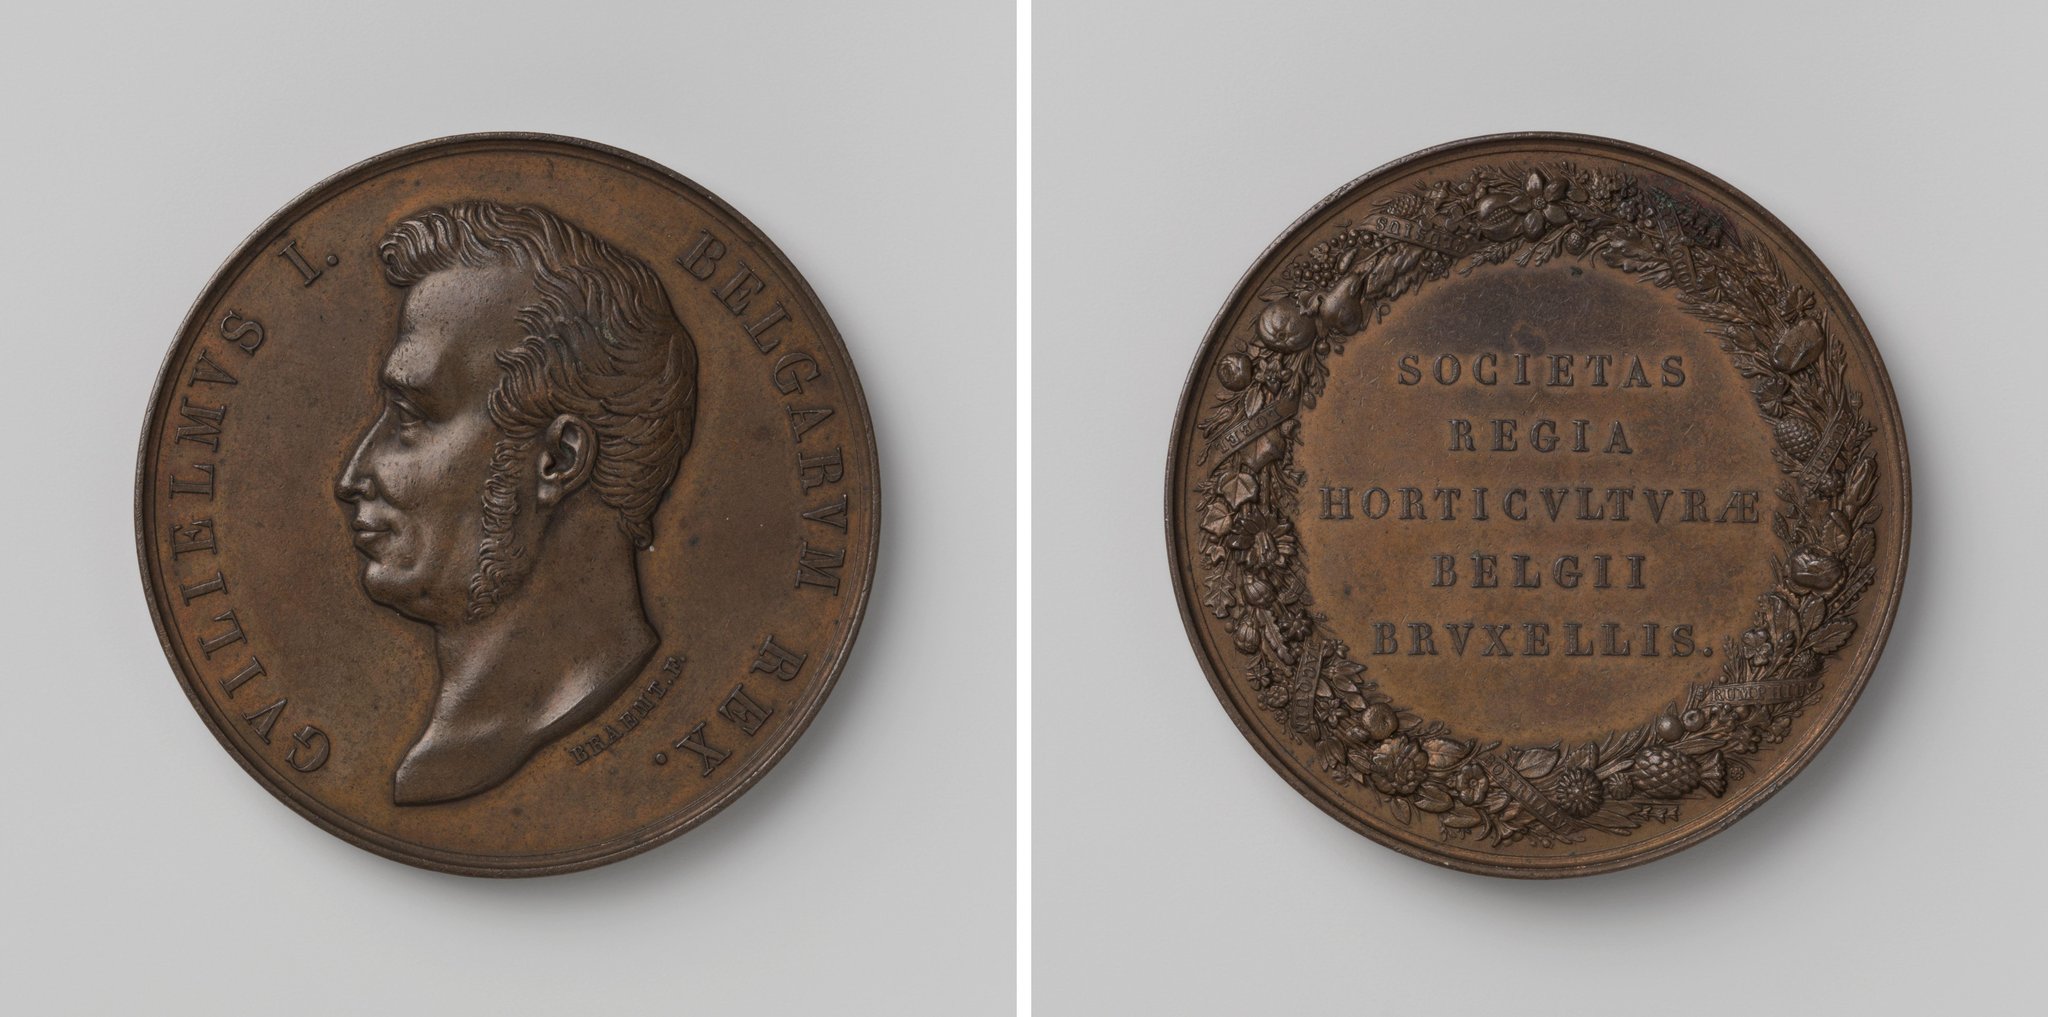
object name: medal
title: Koninklijke Maatschappij van Tuinbouw te Brussel, ter ere van Willem I Frederik, koning der Nederlanden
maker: joseph pierre braemt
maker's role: print maker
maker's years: 1796-1864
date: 1826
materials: bronze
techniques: striking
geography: brussels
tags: the hague, berlin, william i of the netherlands, brussels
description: Bronzen penning. Voorzijde: borststuk man binnen omschrift. Keerzijde: opschrift binnen krans van bloemen en vruchten, omwonden met lint met opschrift